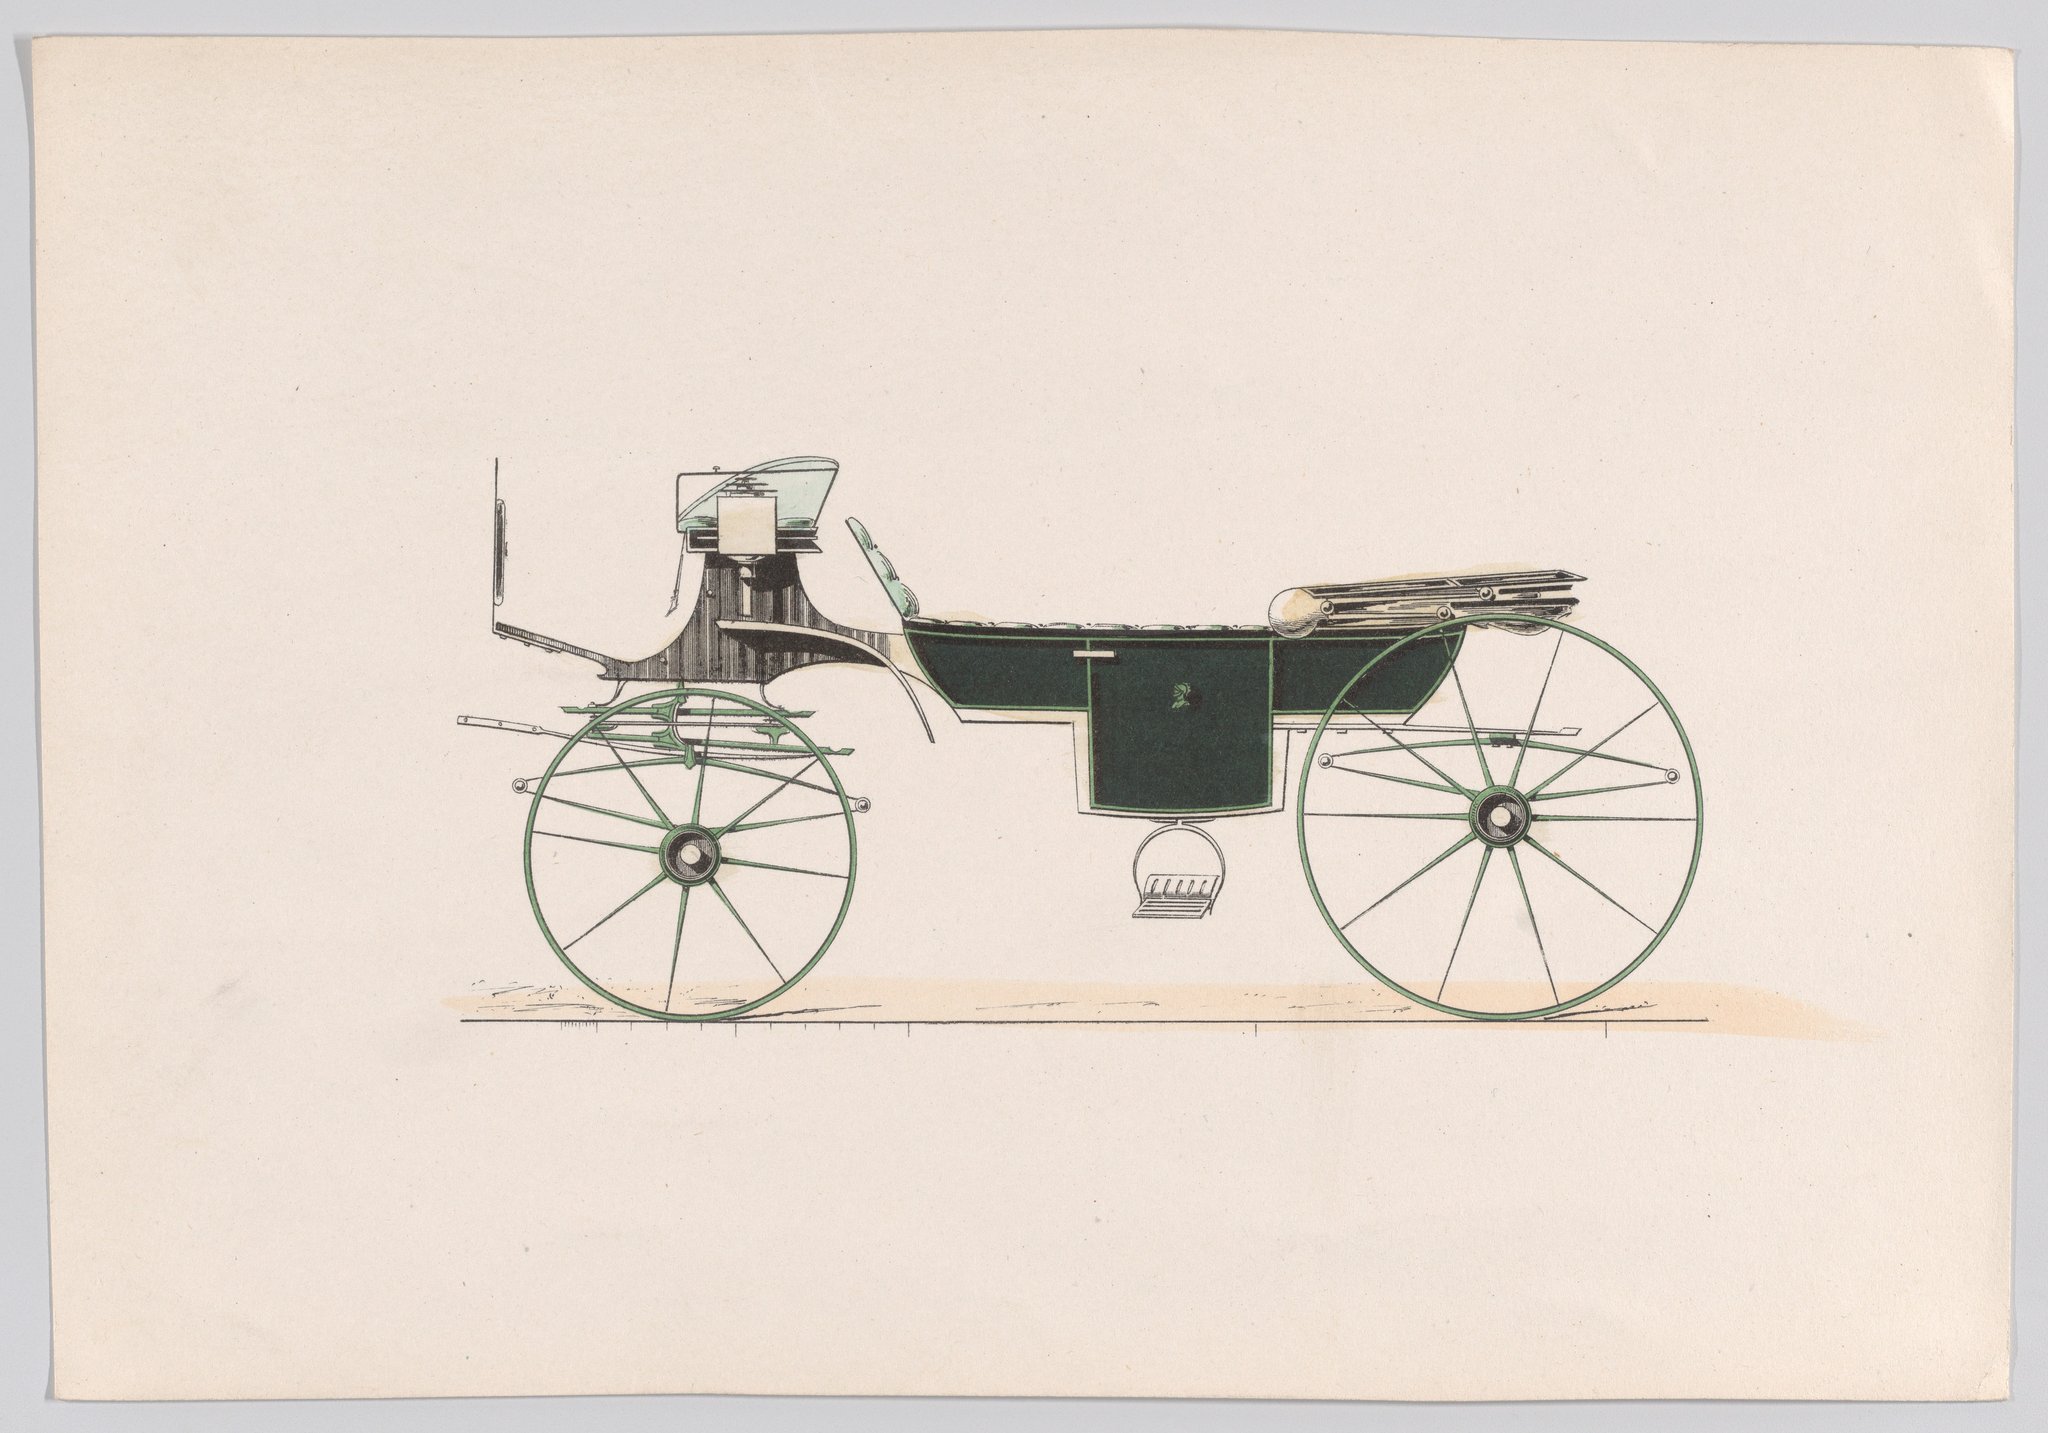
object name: print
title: Design for Vis-A-Vis Carriage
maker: anonymous, french, 19th century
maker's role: artist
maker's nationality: french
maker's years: 1800-1900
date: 1870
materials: gum arabic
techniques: hand coloring, lithograph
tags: carriages